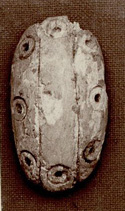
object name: inlay from toilet box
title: Toilet box decoration ?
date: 1981-1640 BCE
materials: ivory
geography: egypt